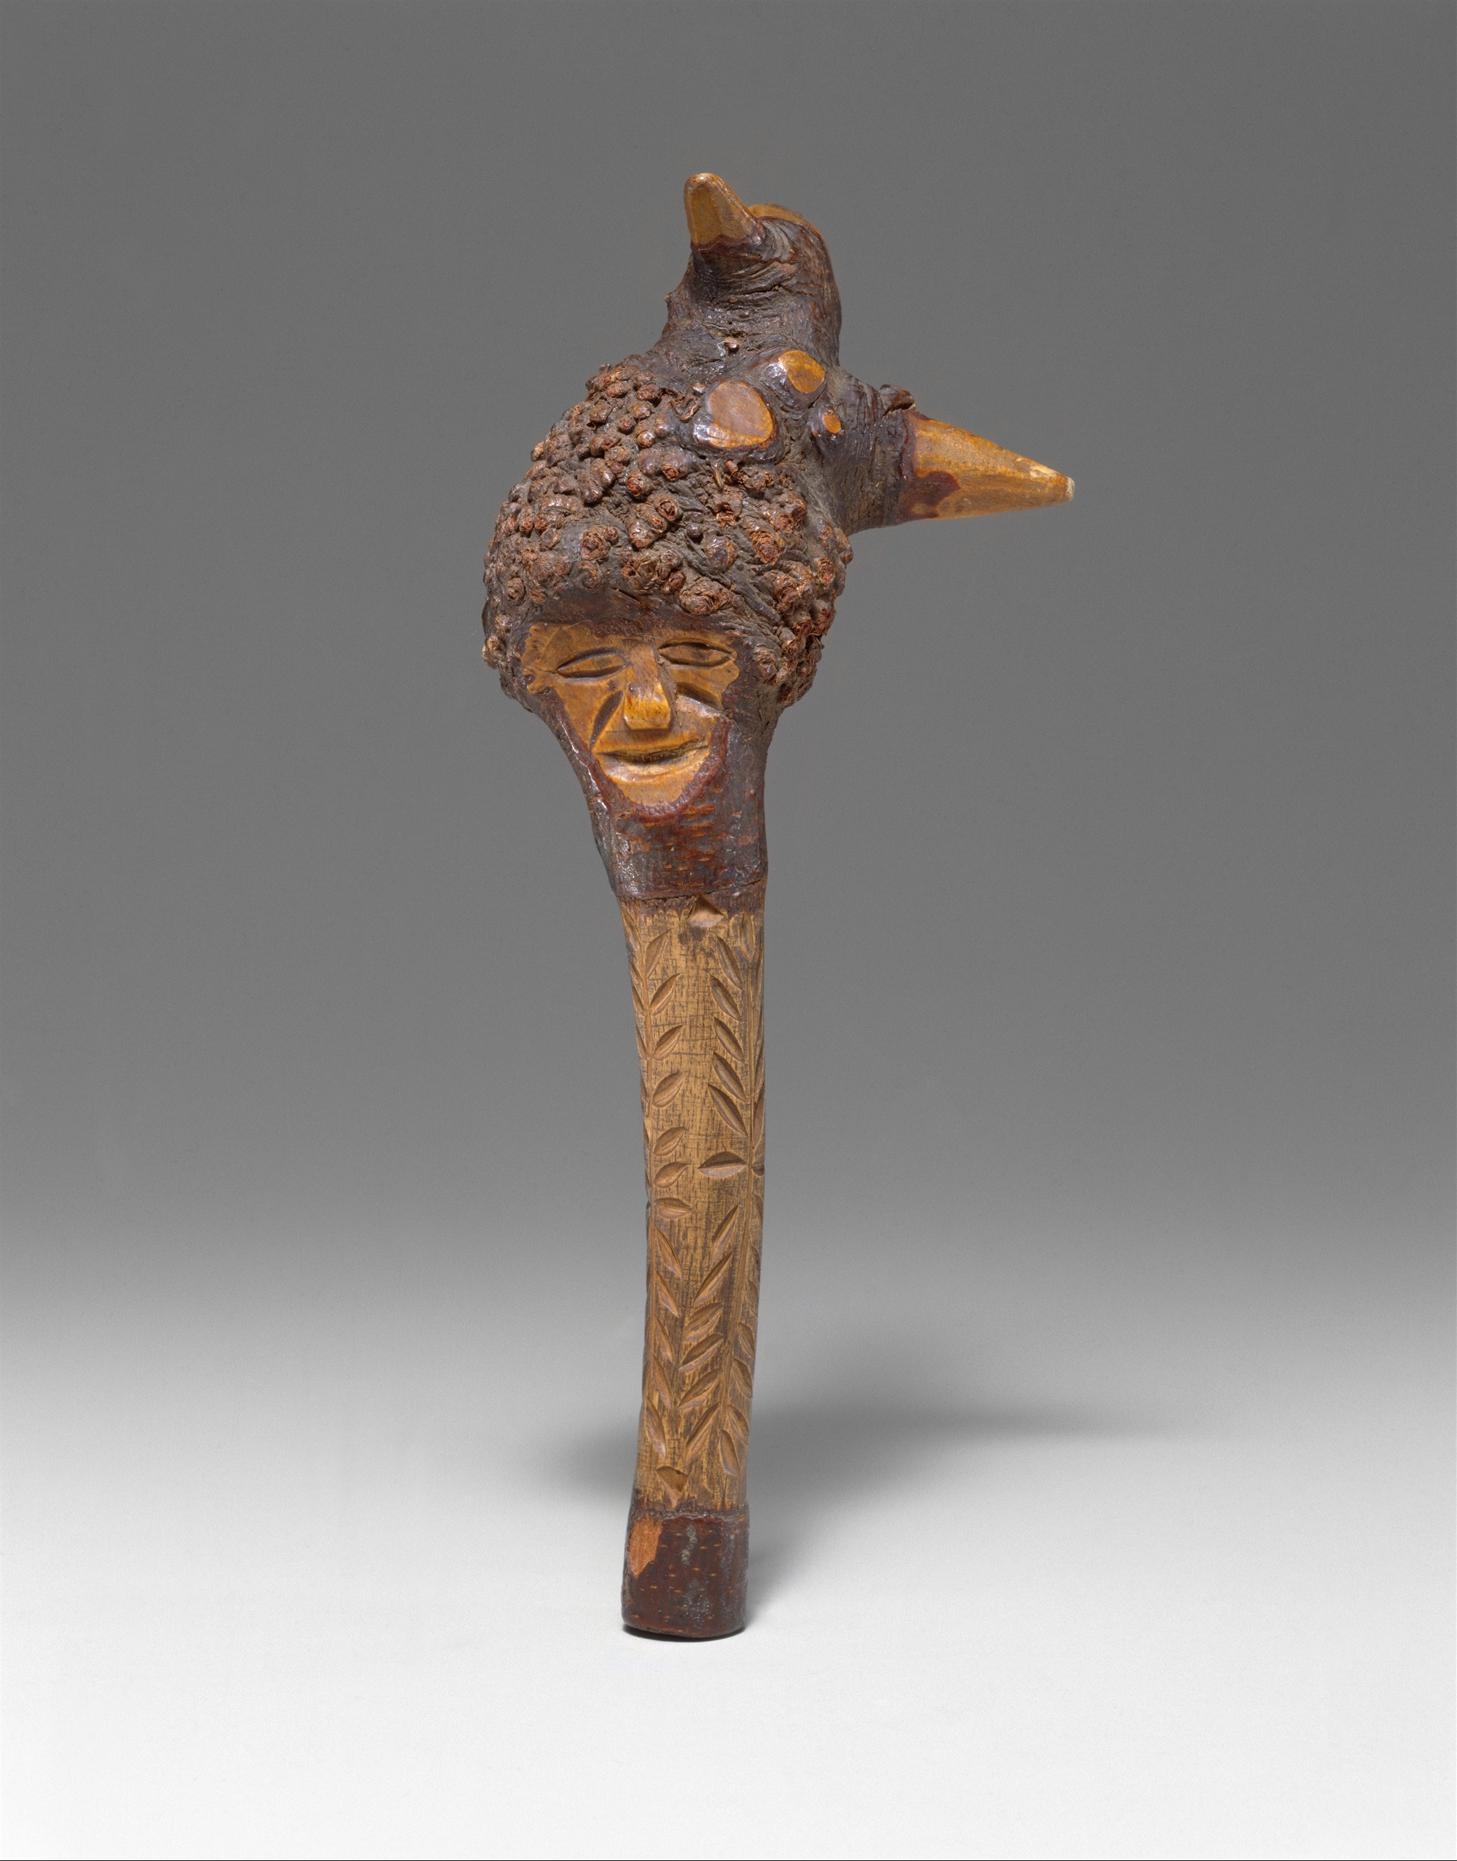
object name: miniature club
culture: penobscot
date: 1860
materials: pigment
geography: united states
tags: weapons,faces